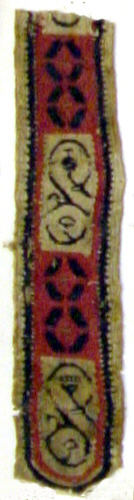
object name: textile fragment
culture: coptic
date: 501-600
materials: linen, wool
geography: egypt